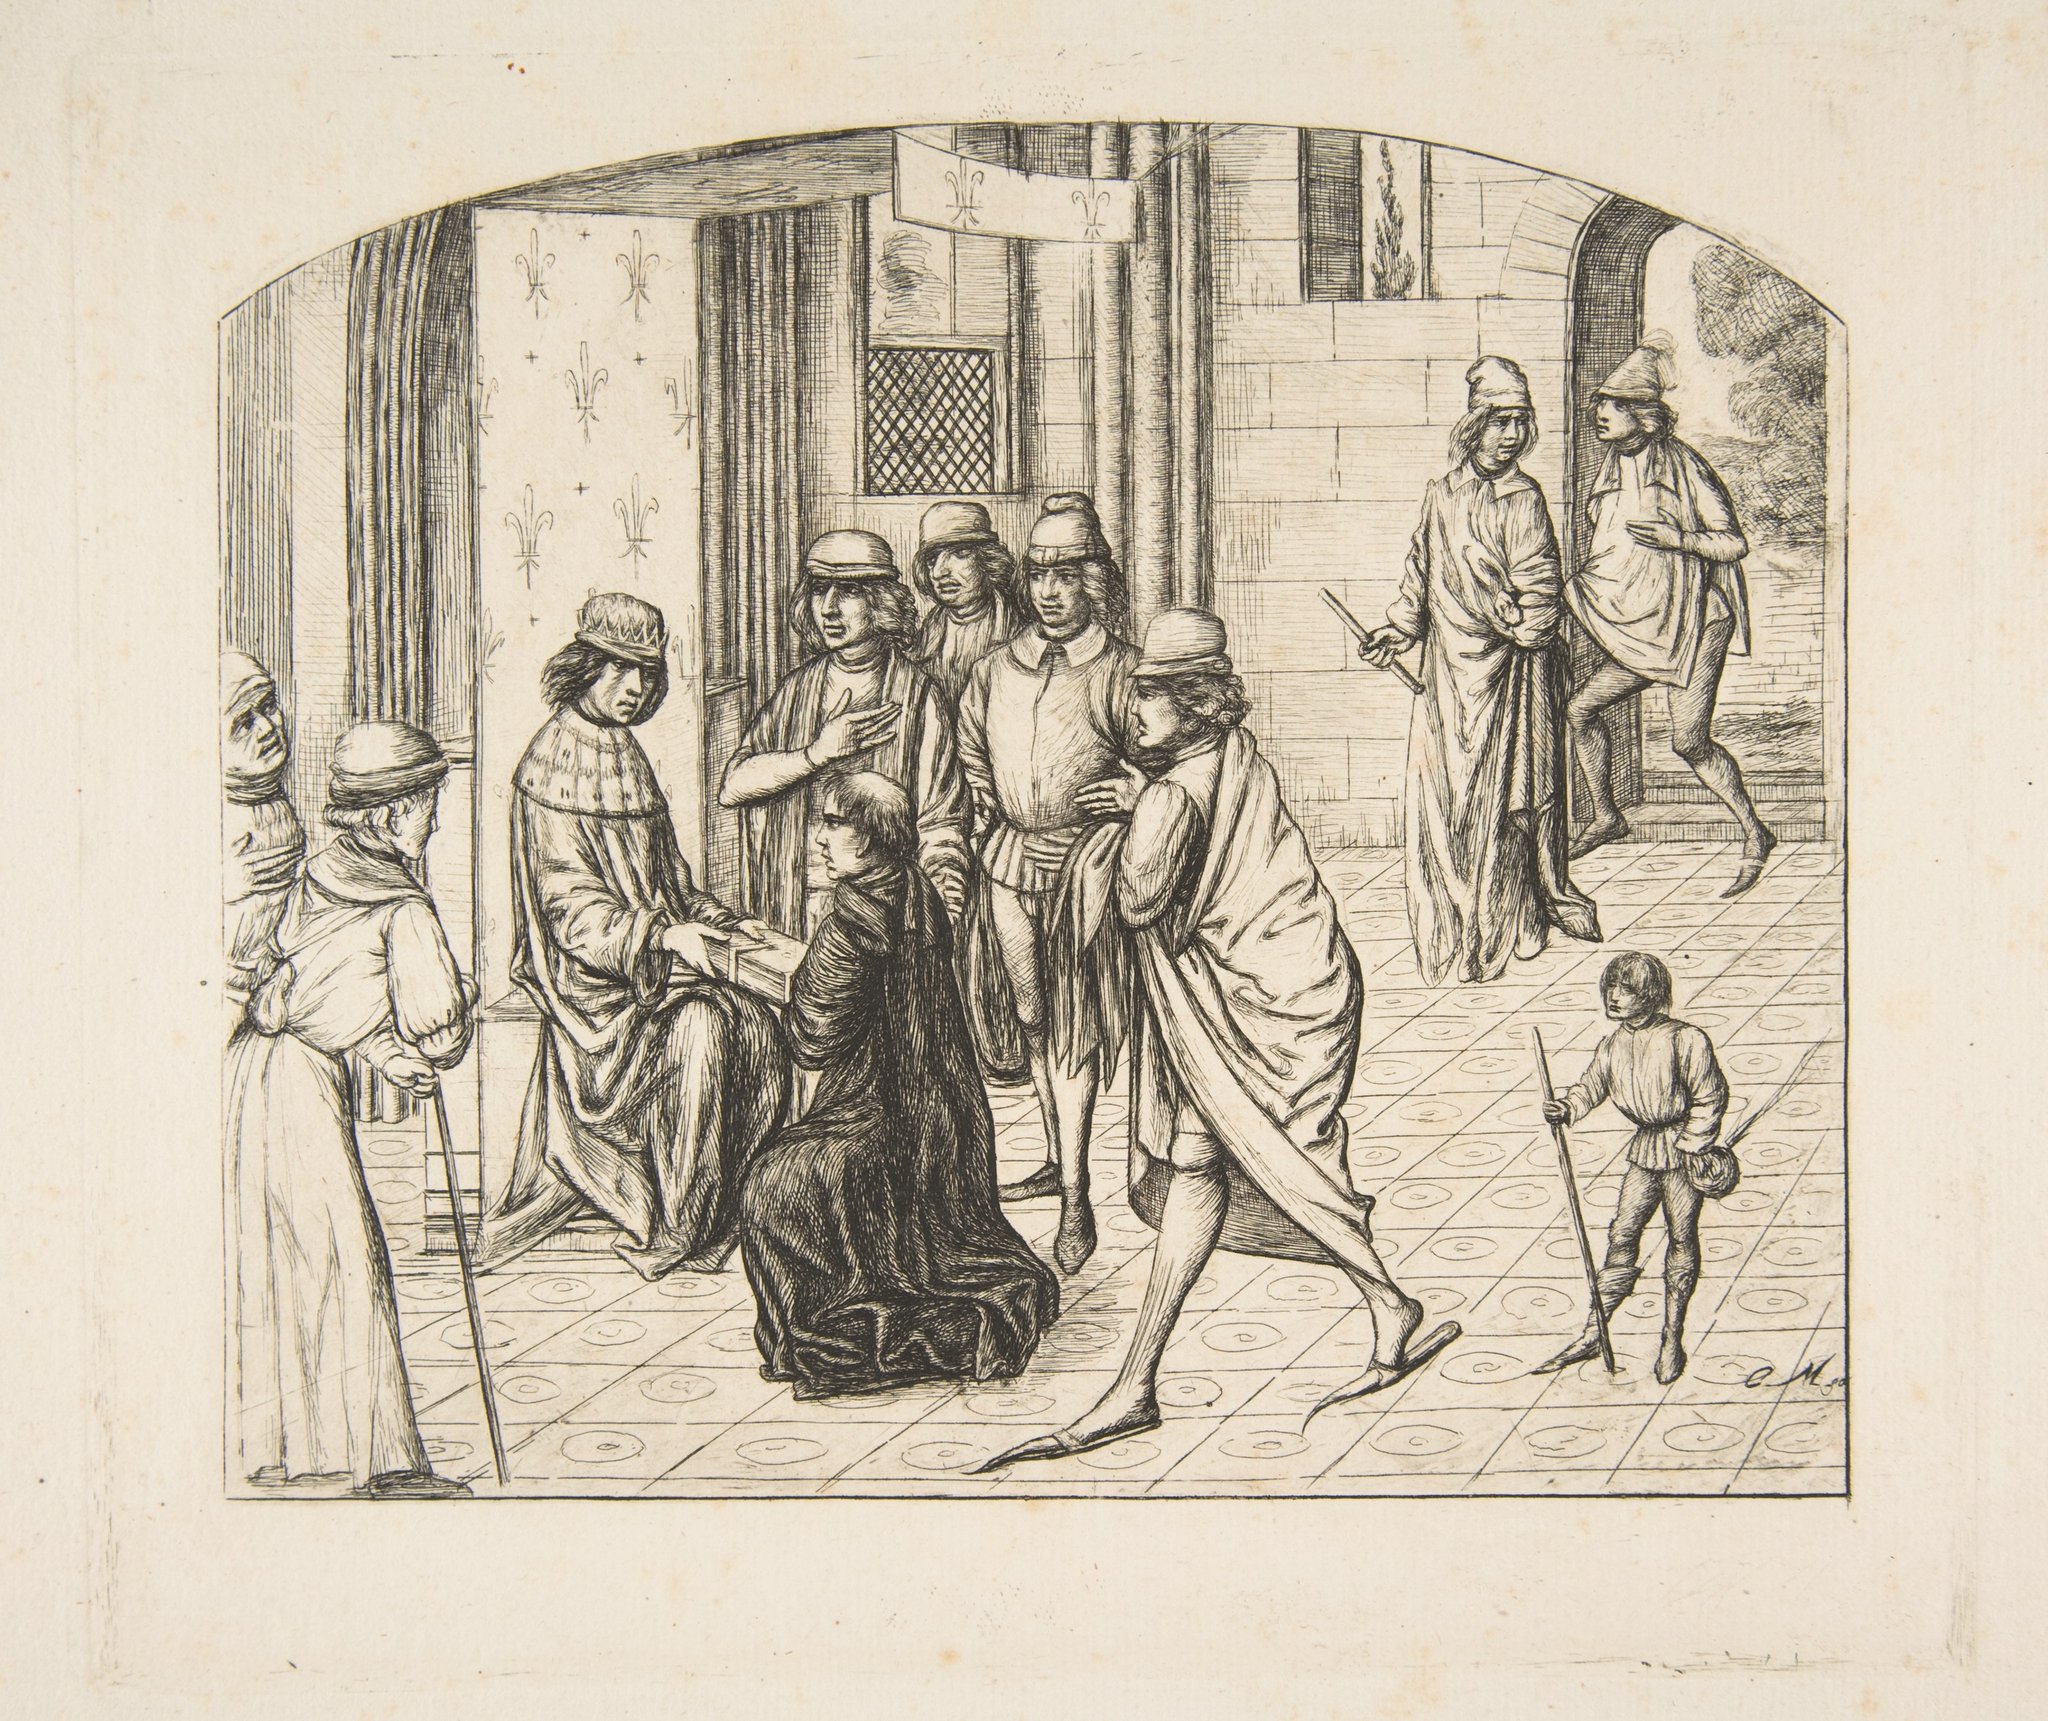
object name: print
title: Presentation of Valerius Maximus to King Louis XI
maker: charles meryon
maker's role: artist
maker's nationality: french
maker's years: 1821-1868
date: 1862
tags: kings,boys,men